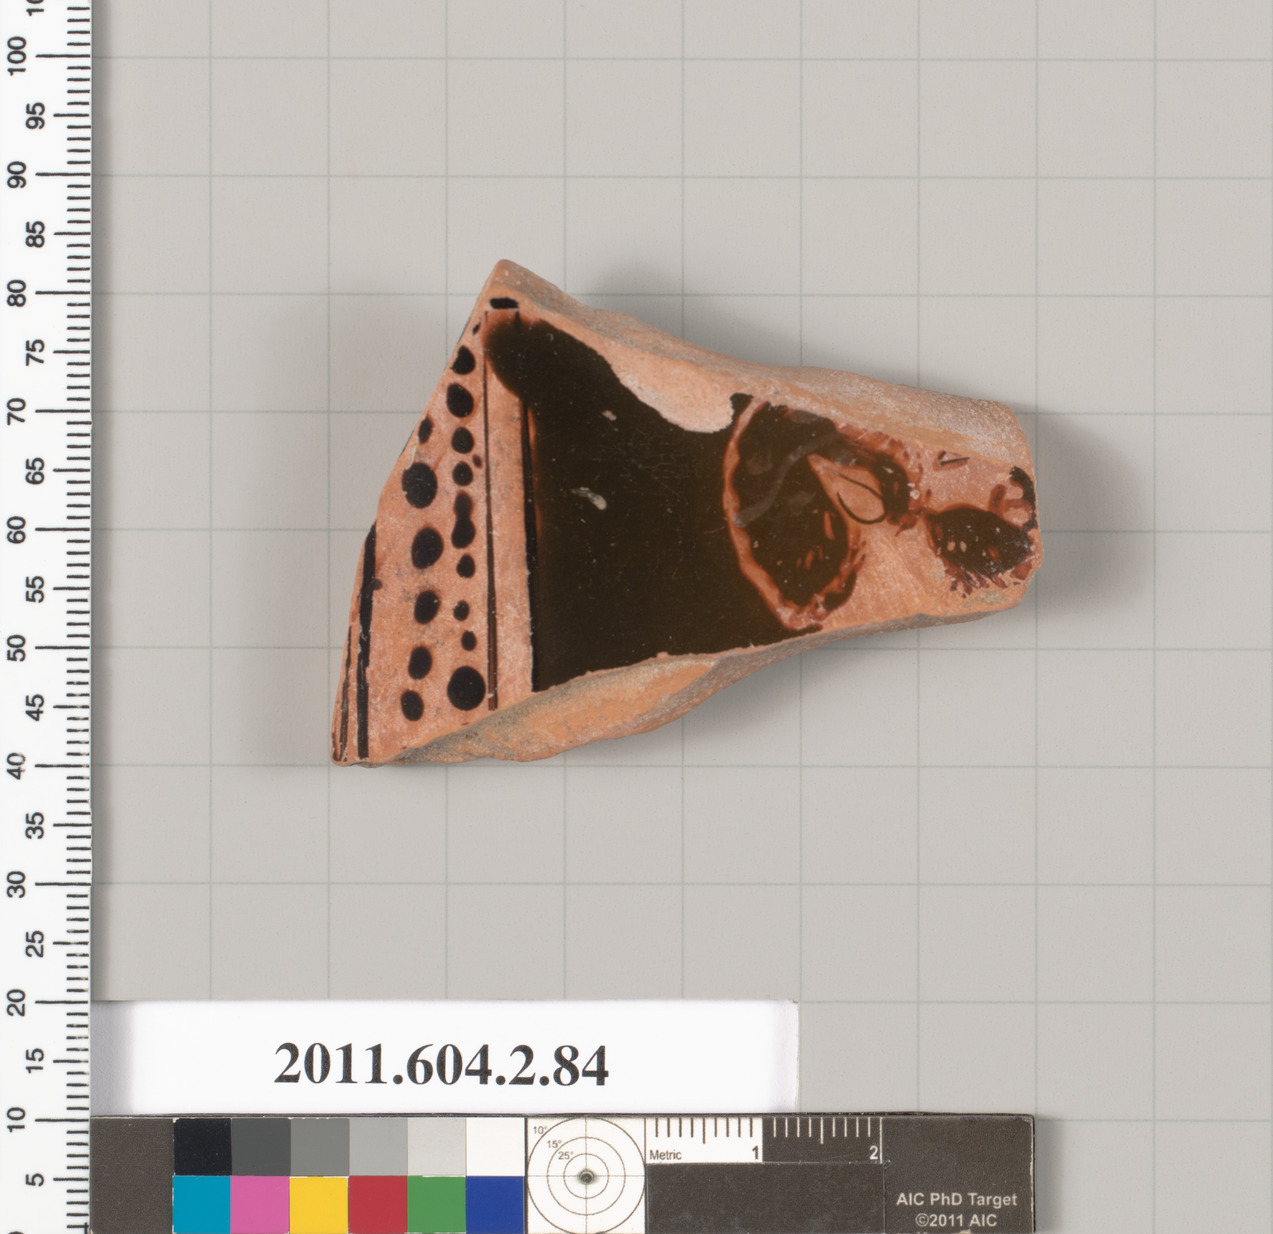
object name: pelike fragment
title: Terracotta fragment of a pelike (jar)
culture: greek, attic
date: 440-430 BCE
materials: terracotta